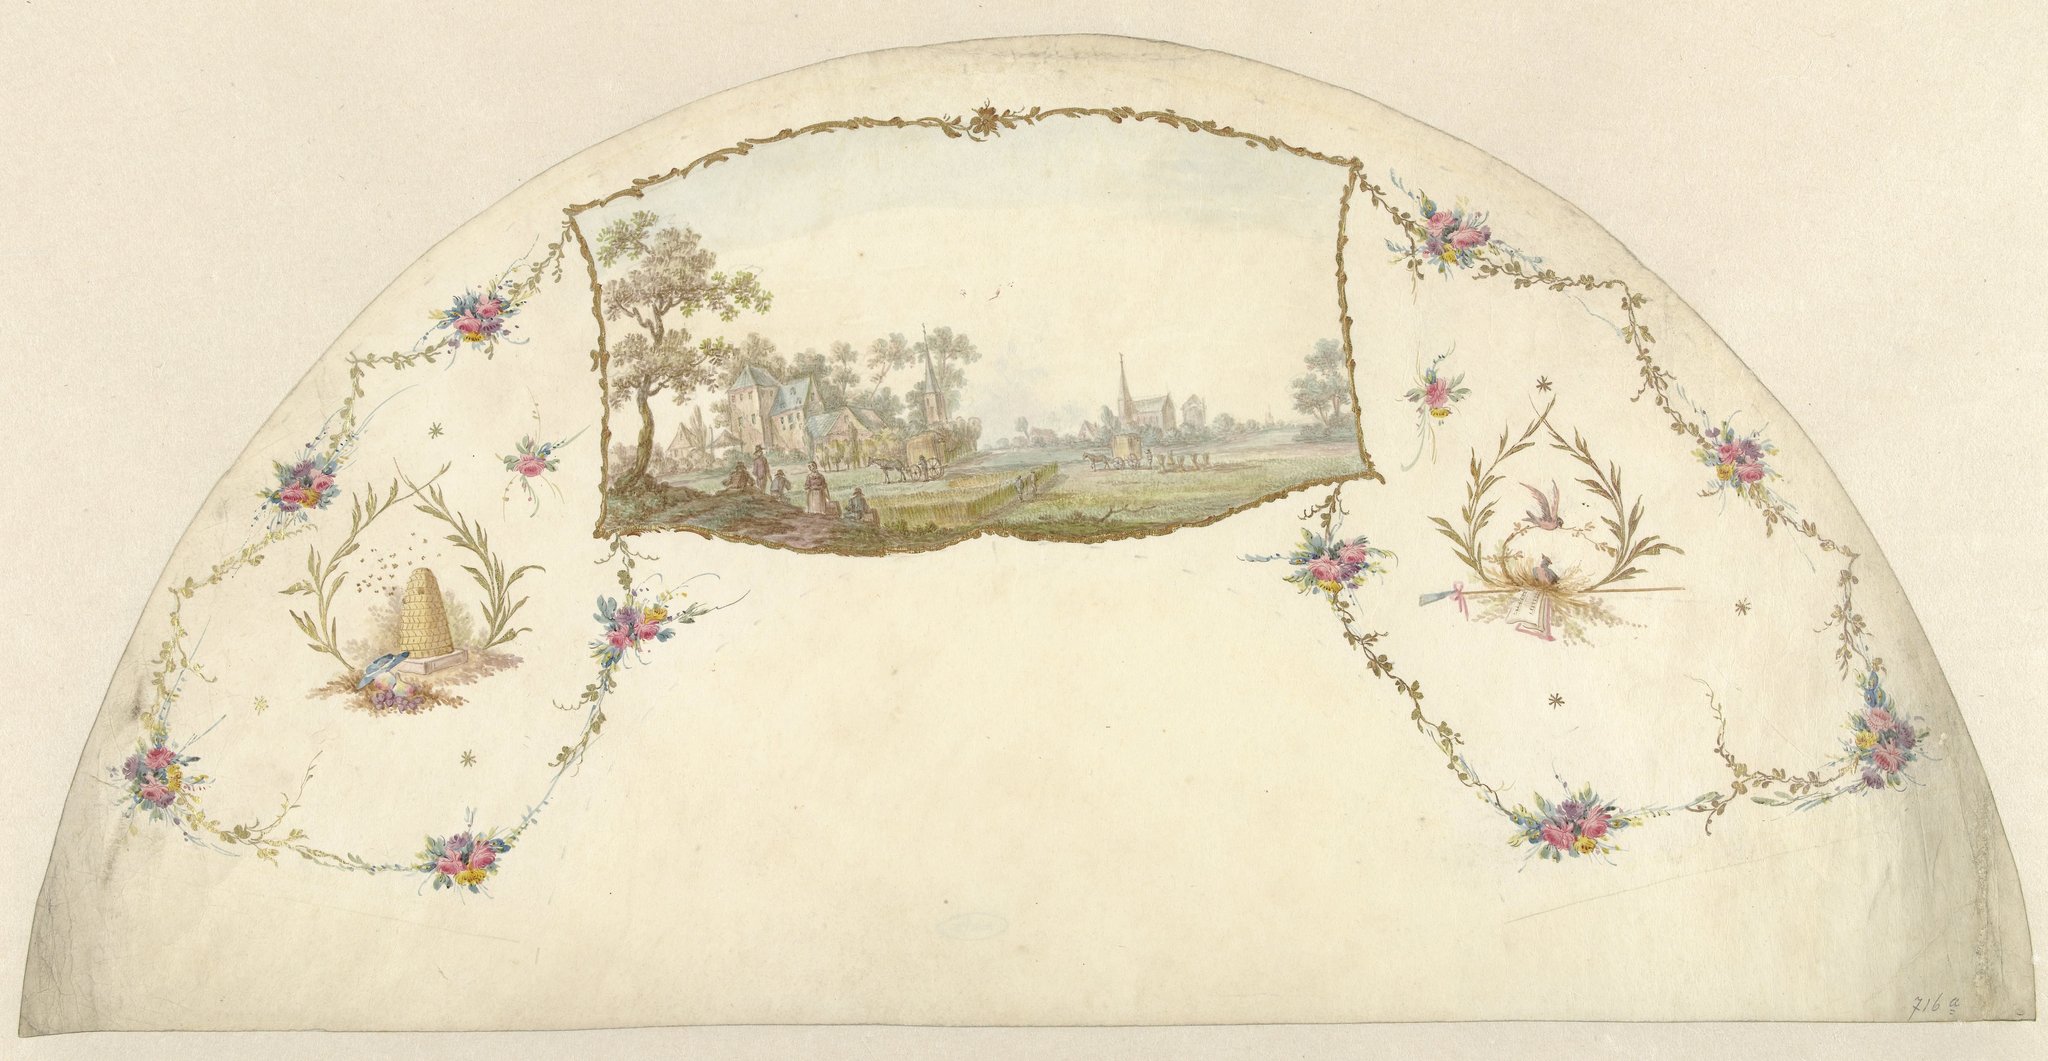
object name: design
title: Two Fan Leaves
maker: Anonymous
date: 1780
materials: paint, parchment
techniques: brush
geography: netherlands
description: The upper fan leaf is an ode to summer country life: haying is being done just outside the village limits. Two birds hovering around their nest flank this scene on the right. The hard work underlying the peaceful bucolic imagery is referred to by the beehive on the left, a prominent symbol of diligence. The lower fan leaf features putti offering flowers to a woman. This is flanked by two scenes of so-called chinoiserie, motifs inspired by Chinese art that were highly popular at the time.